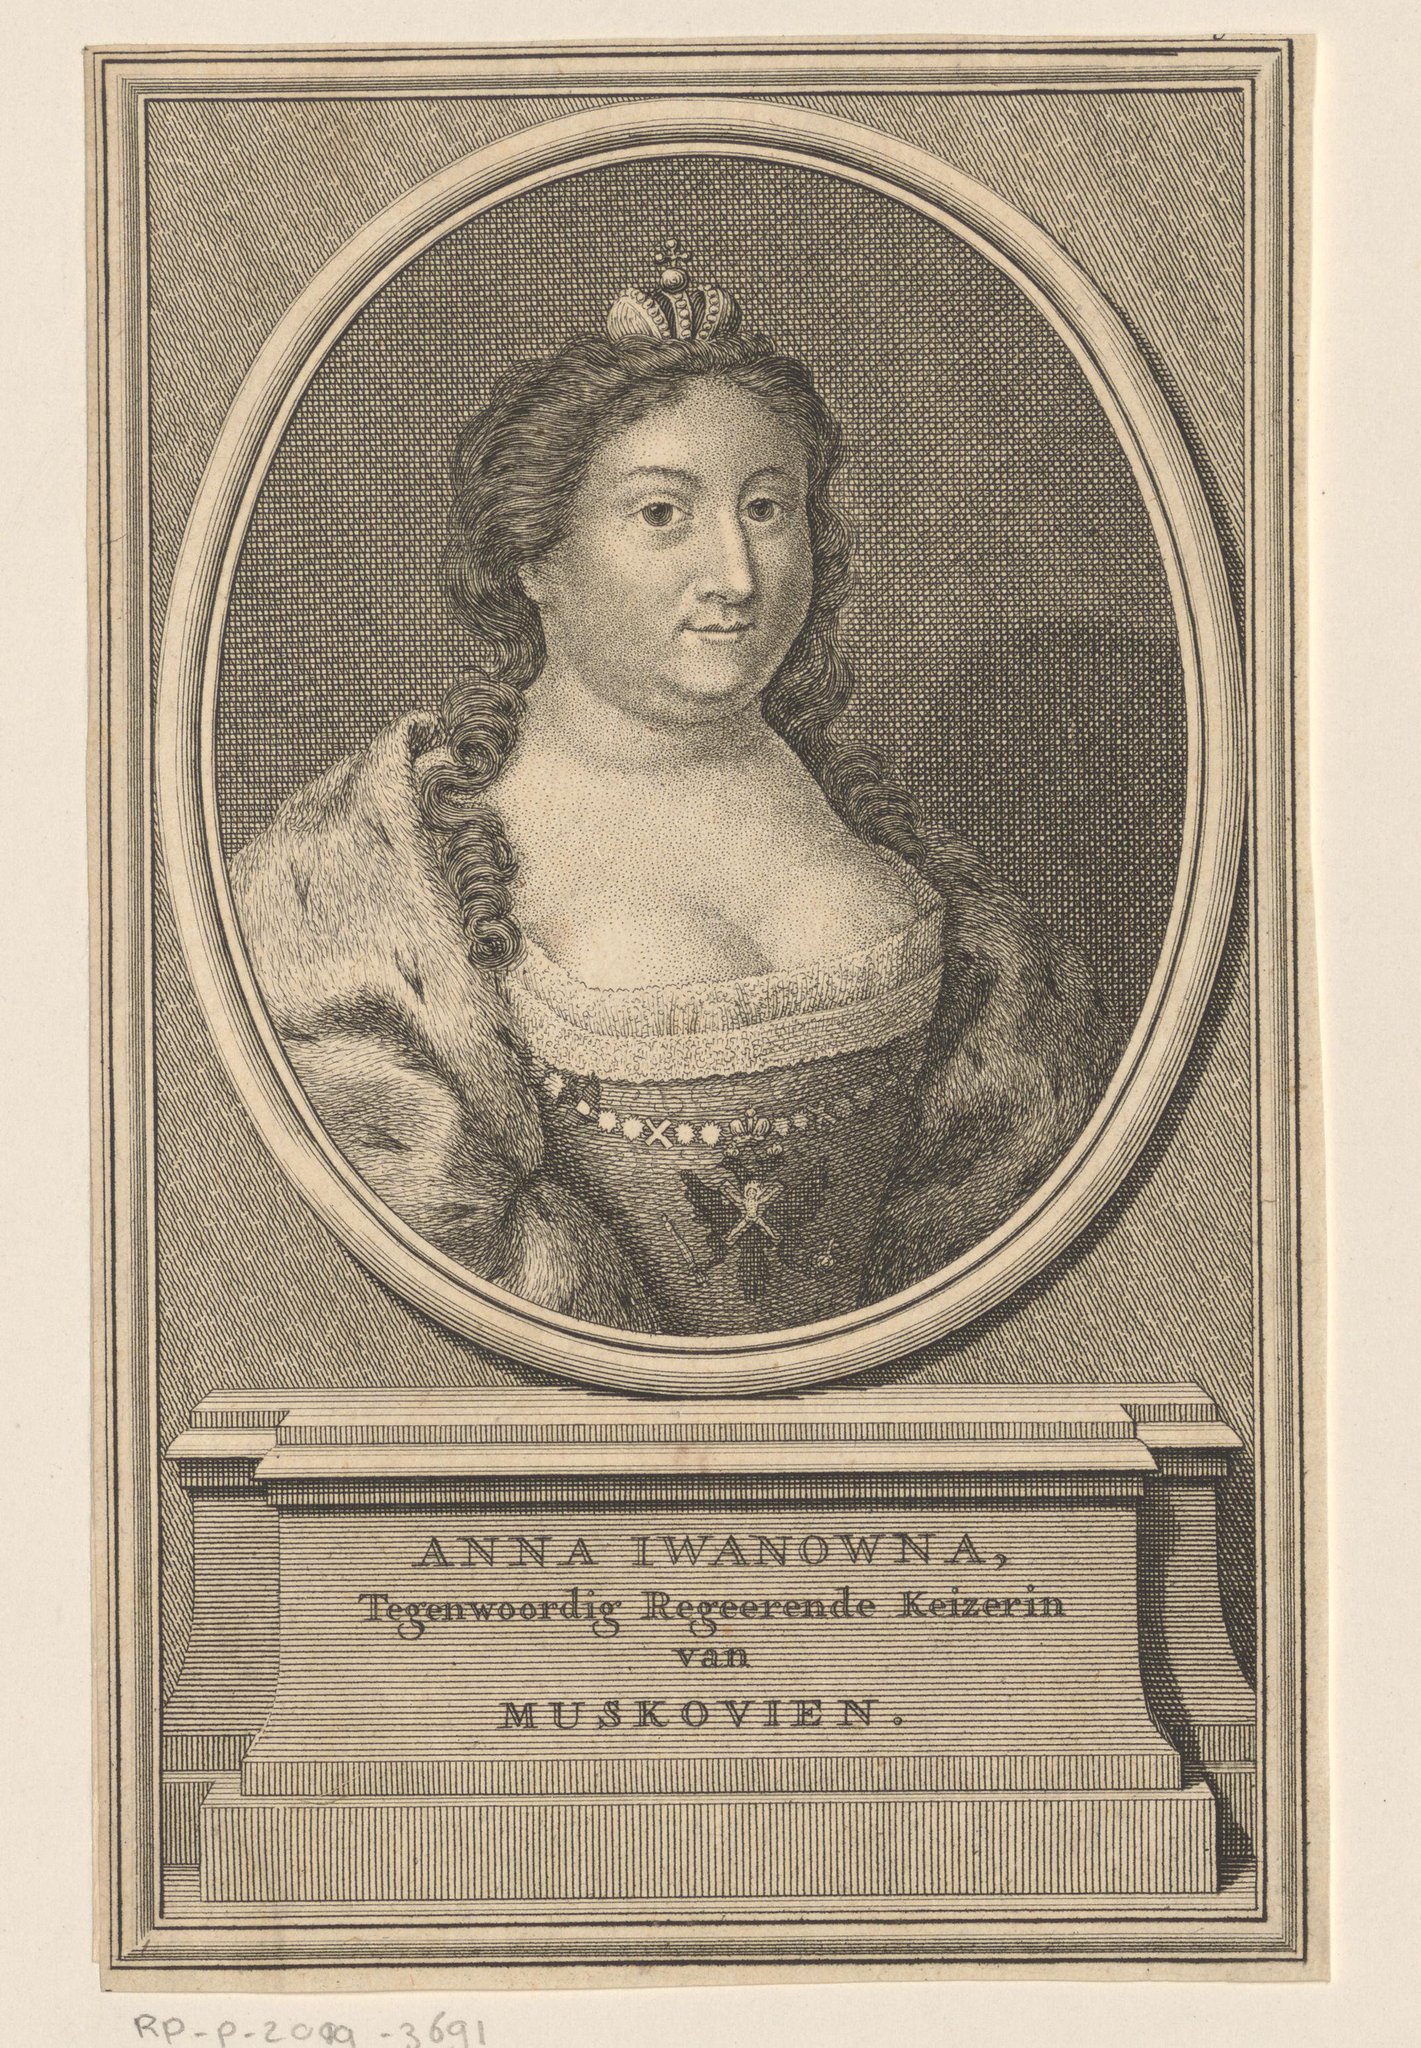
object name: print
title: Portret van Anna Ivanovna, tsarina van Rusland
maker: Anonymous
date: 1730-1740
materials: paper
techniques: engraving, etching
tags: historical persons - bb - woman, emperor - bb - female ruler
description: Oorspronkelijk rechtsboven genummerd, hier weggesneden.